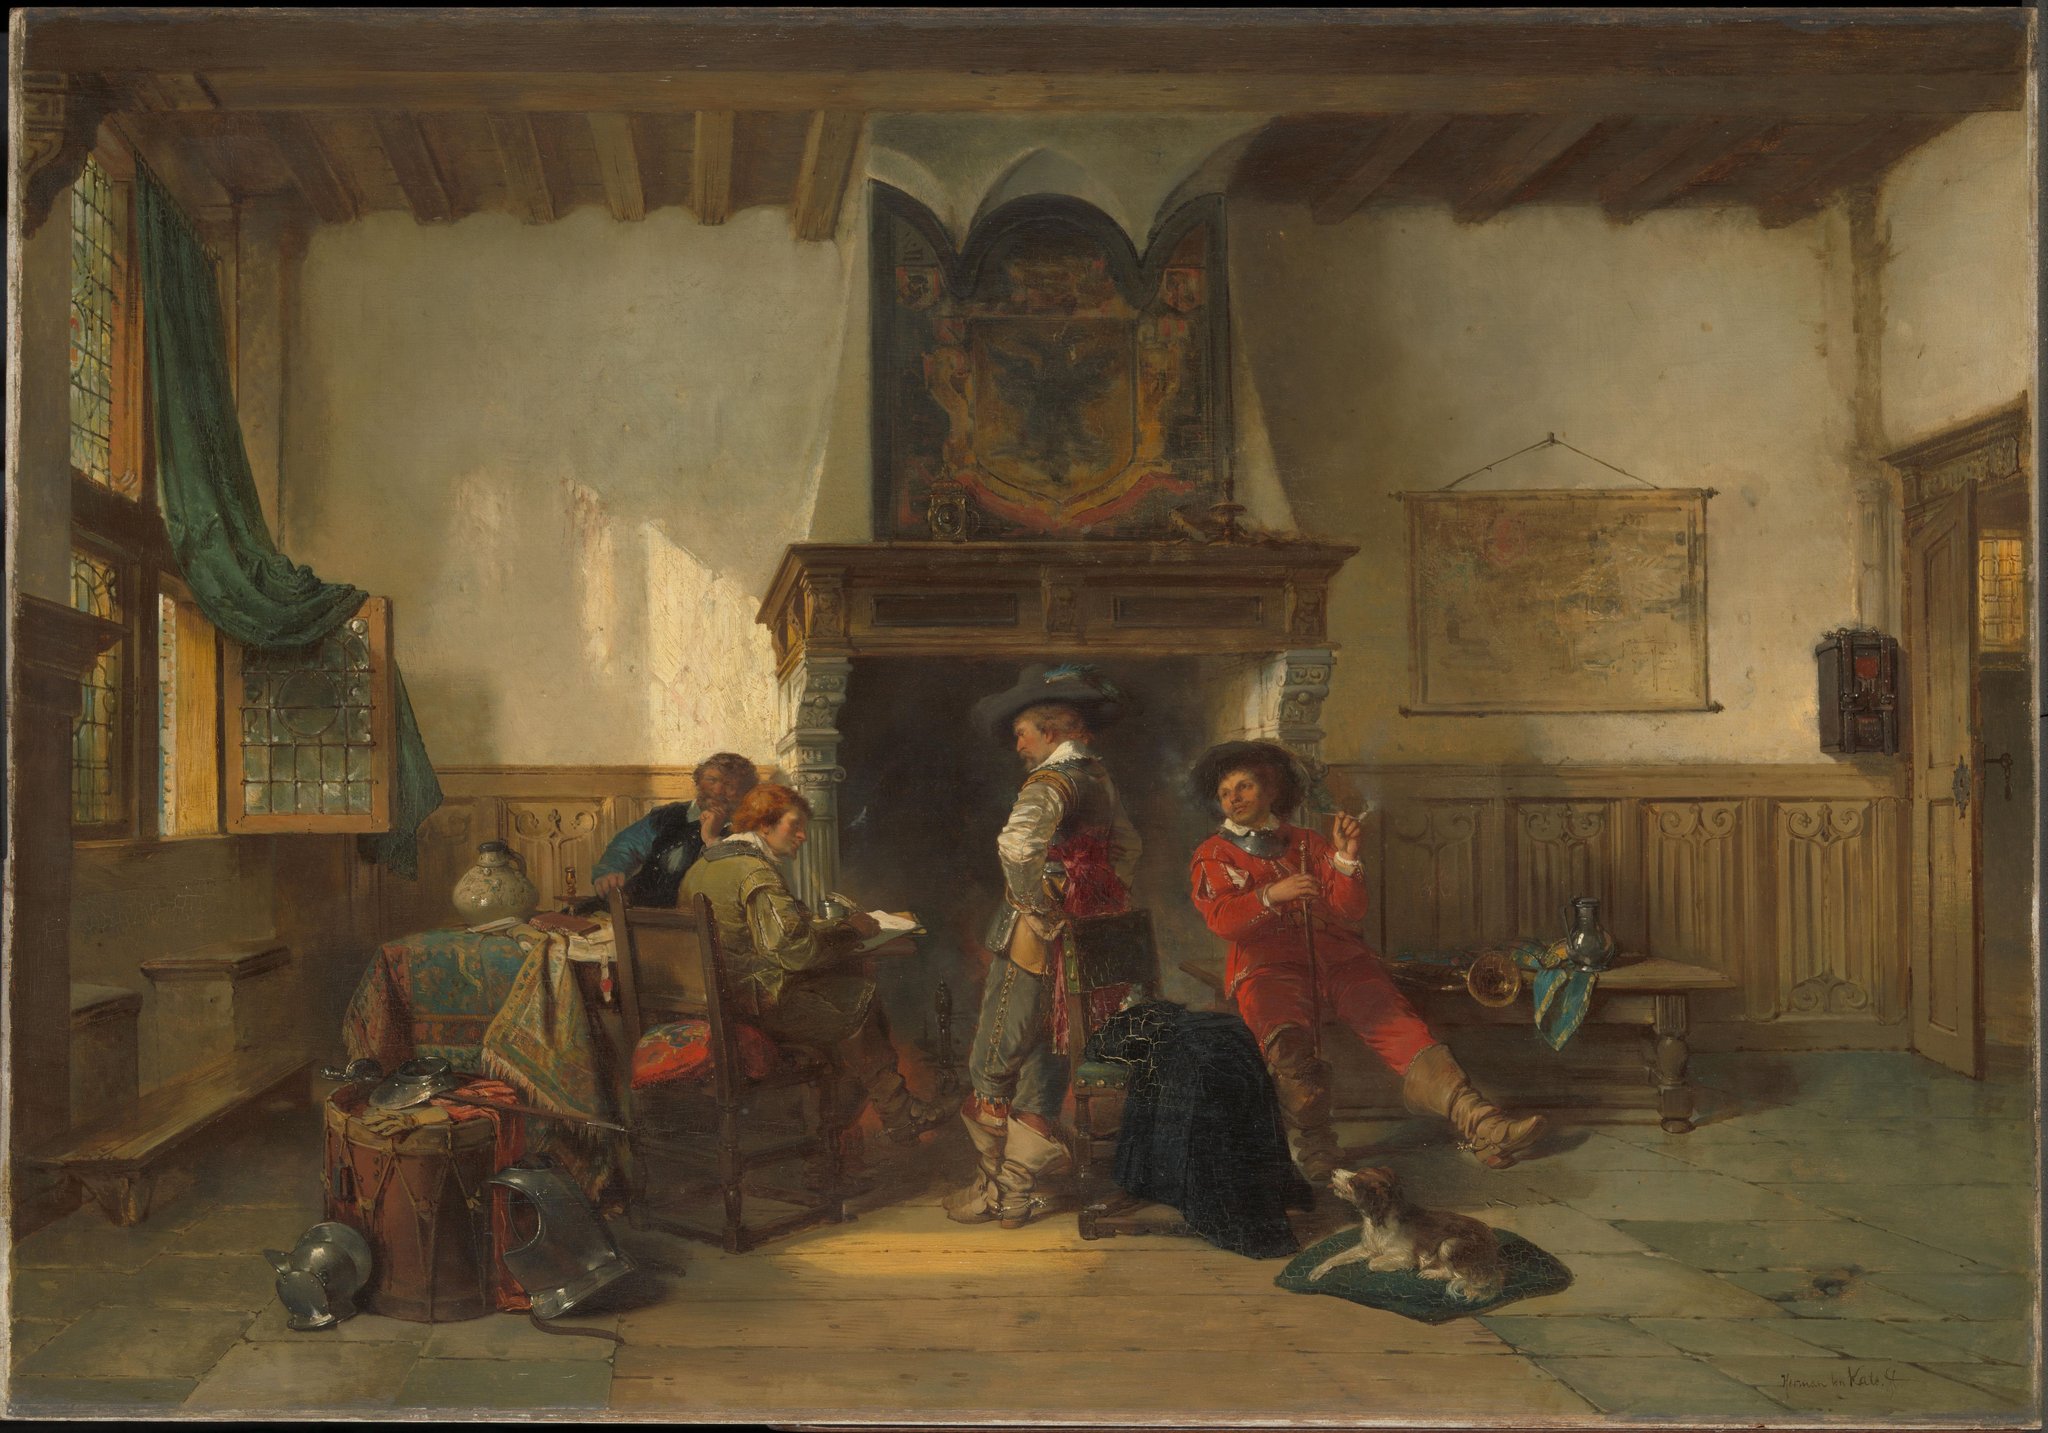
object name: painting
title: Soldiers in a Guardsroom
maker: herman frederik carel ten kate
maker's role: draughtsman, painter, print maker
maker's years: 1822-1891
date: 1865-1867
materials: oil, panel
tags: in the guard-room, 'kortegaard'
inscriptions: signature: ‘Herman ten Kate ft.’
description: Wachtkamer met vier soldaten aan tafels voor een haard. Een soldaat links schrijft een brief. Op de vloer staan delen wapenrusting en een trommel, op de voorgrond ligt een hond op een mat. Rechts aan de achterwand hangt een kaart op rollen. Boven de schouw een wapen met een adelaar.